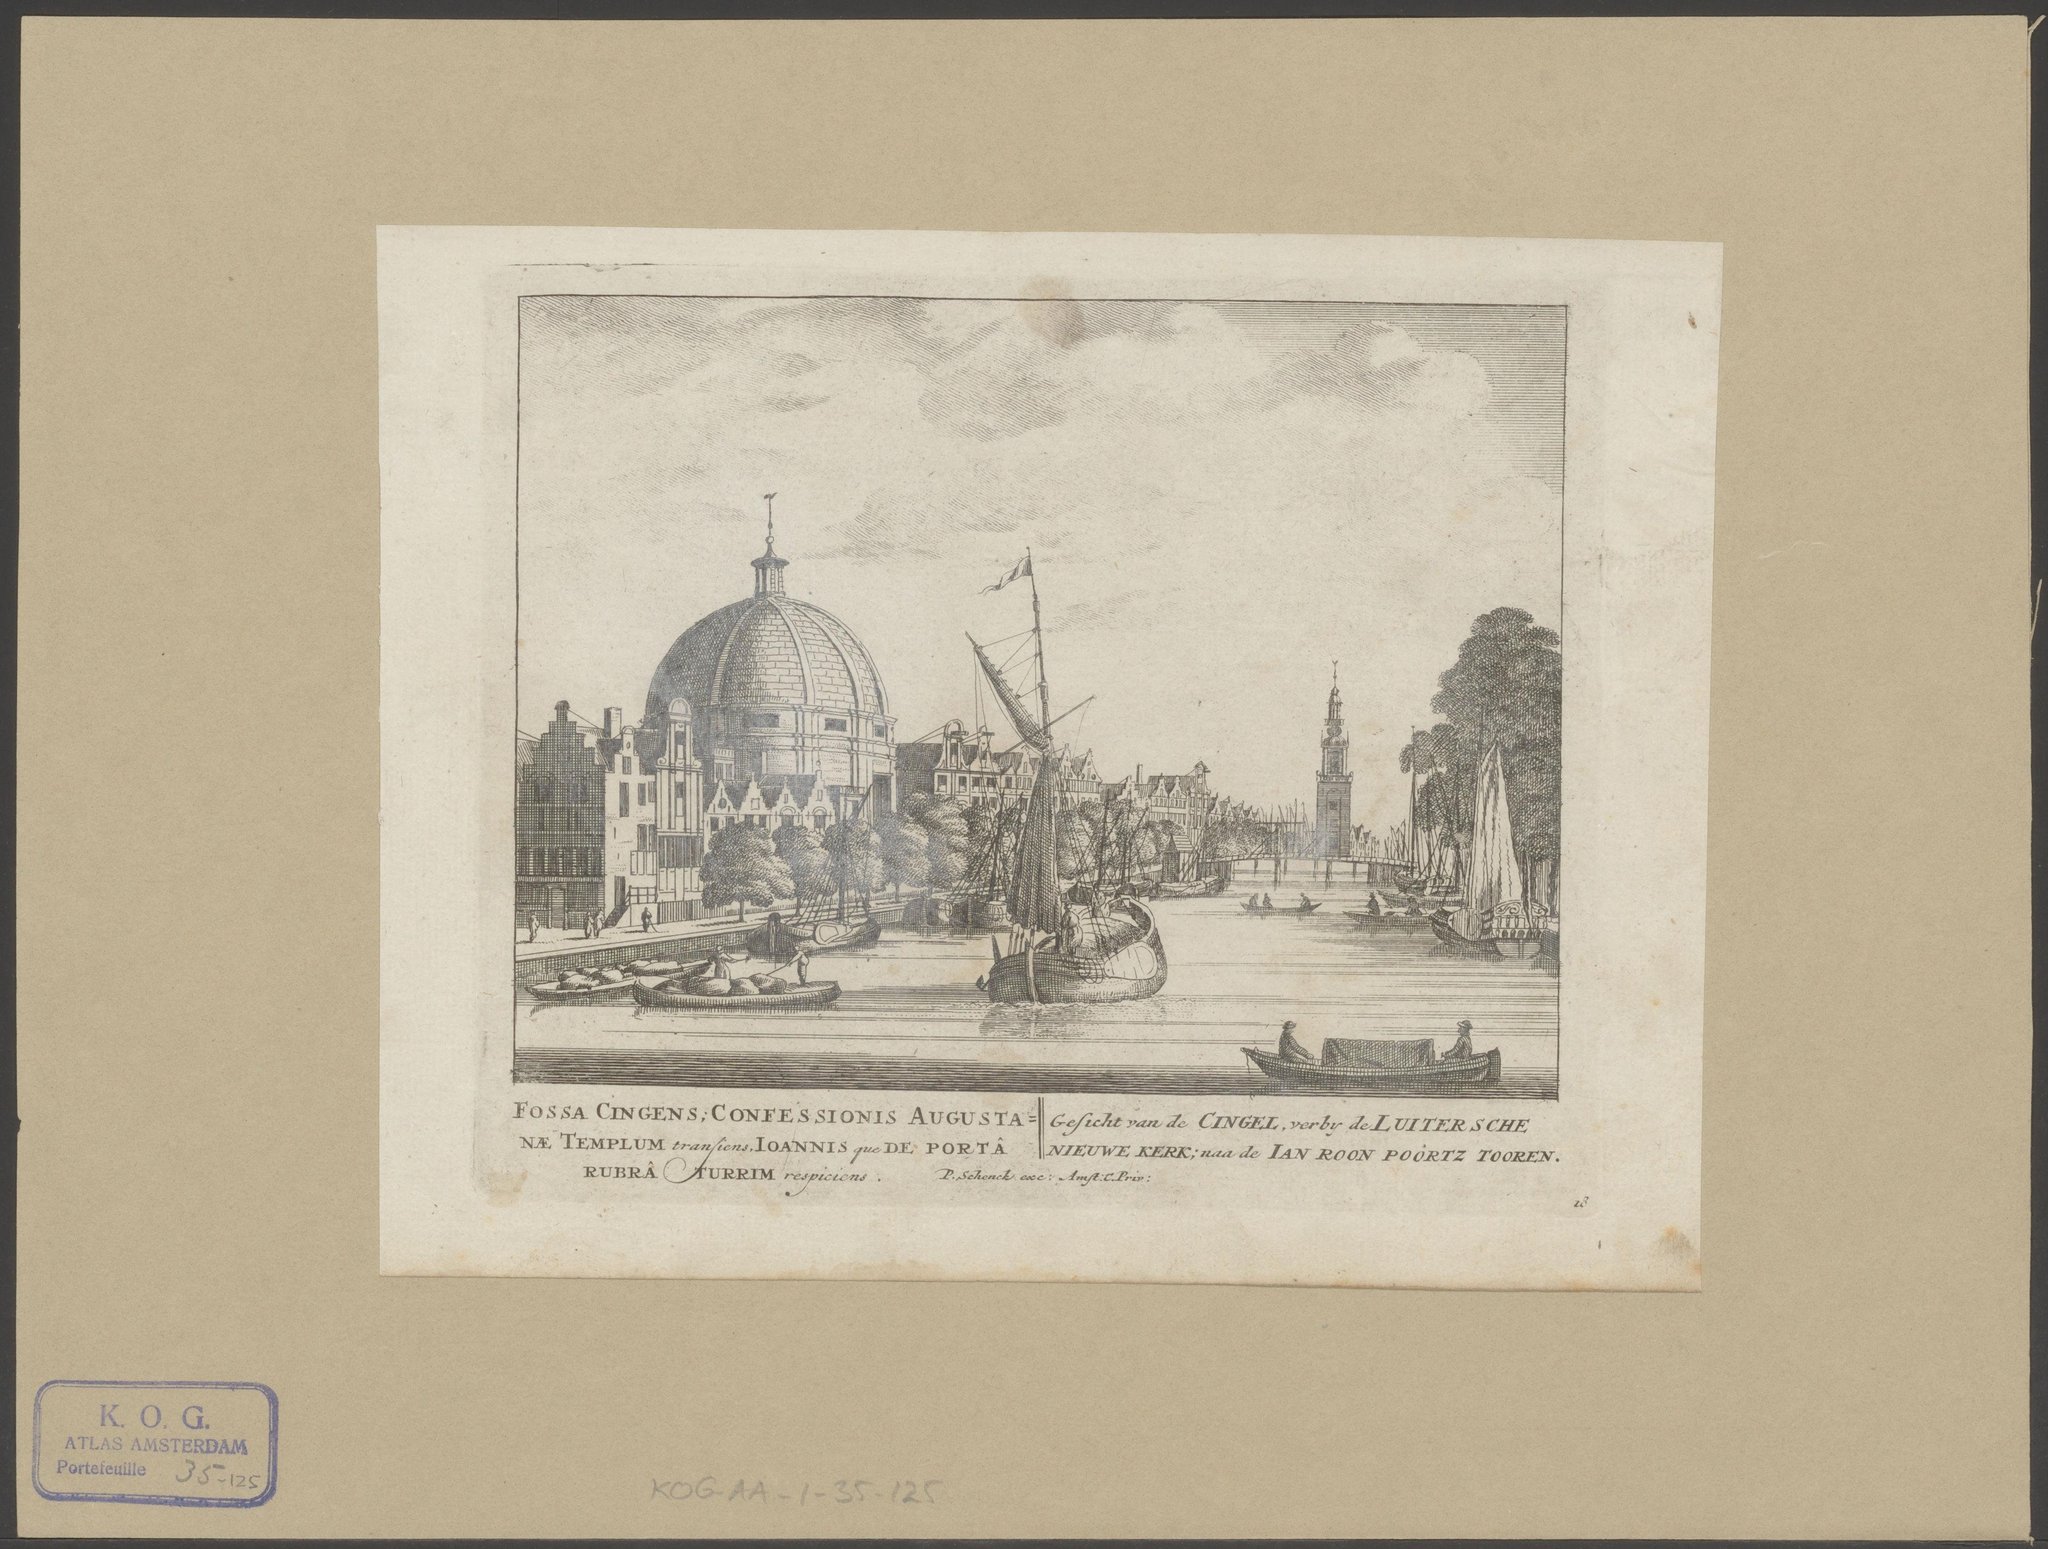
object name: book illustration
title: Gezicht op het Singel naar de Ronde Lutherse kerk en de Jan Rodenpoortstoren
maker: Anonymous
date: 1710-1711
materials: paper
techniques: etching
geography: northern netherlands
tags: protestant churches and denominations (lutherans), tower, clock tower ~ monumental adornment, parts of church exterior and annexes: dome, canals, waters (in city) (+ city(-scape) with figures, staffage)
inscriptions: collector's mark: ‘35-125’ Lugt 1641b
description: Huidige staat van prent ook gebruikt in: 100 Afbeeldinge der voornaamste gebouwen van Amsterdam. Amsterdam, Pieter Schenk (I), s.a. [1710-1711]. En in: 100 Afbeeldinge der voornaamste gebouwen van Amsterdam. Amsterdam, Barent Greve, s.a. [1757-1766].* *In de tweede uitgave, uitgegeven door Barent Greve, is alleen de titelprent aangepast. De overige prenten zijn onveranderd gebleven.